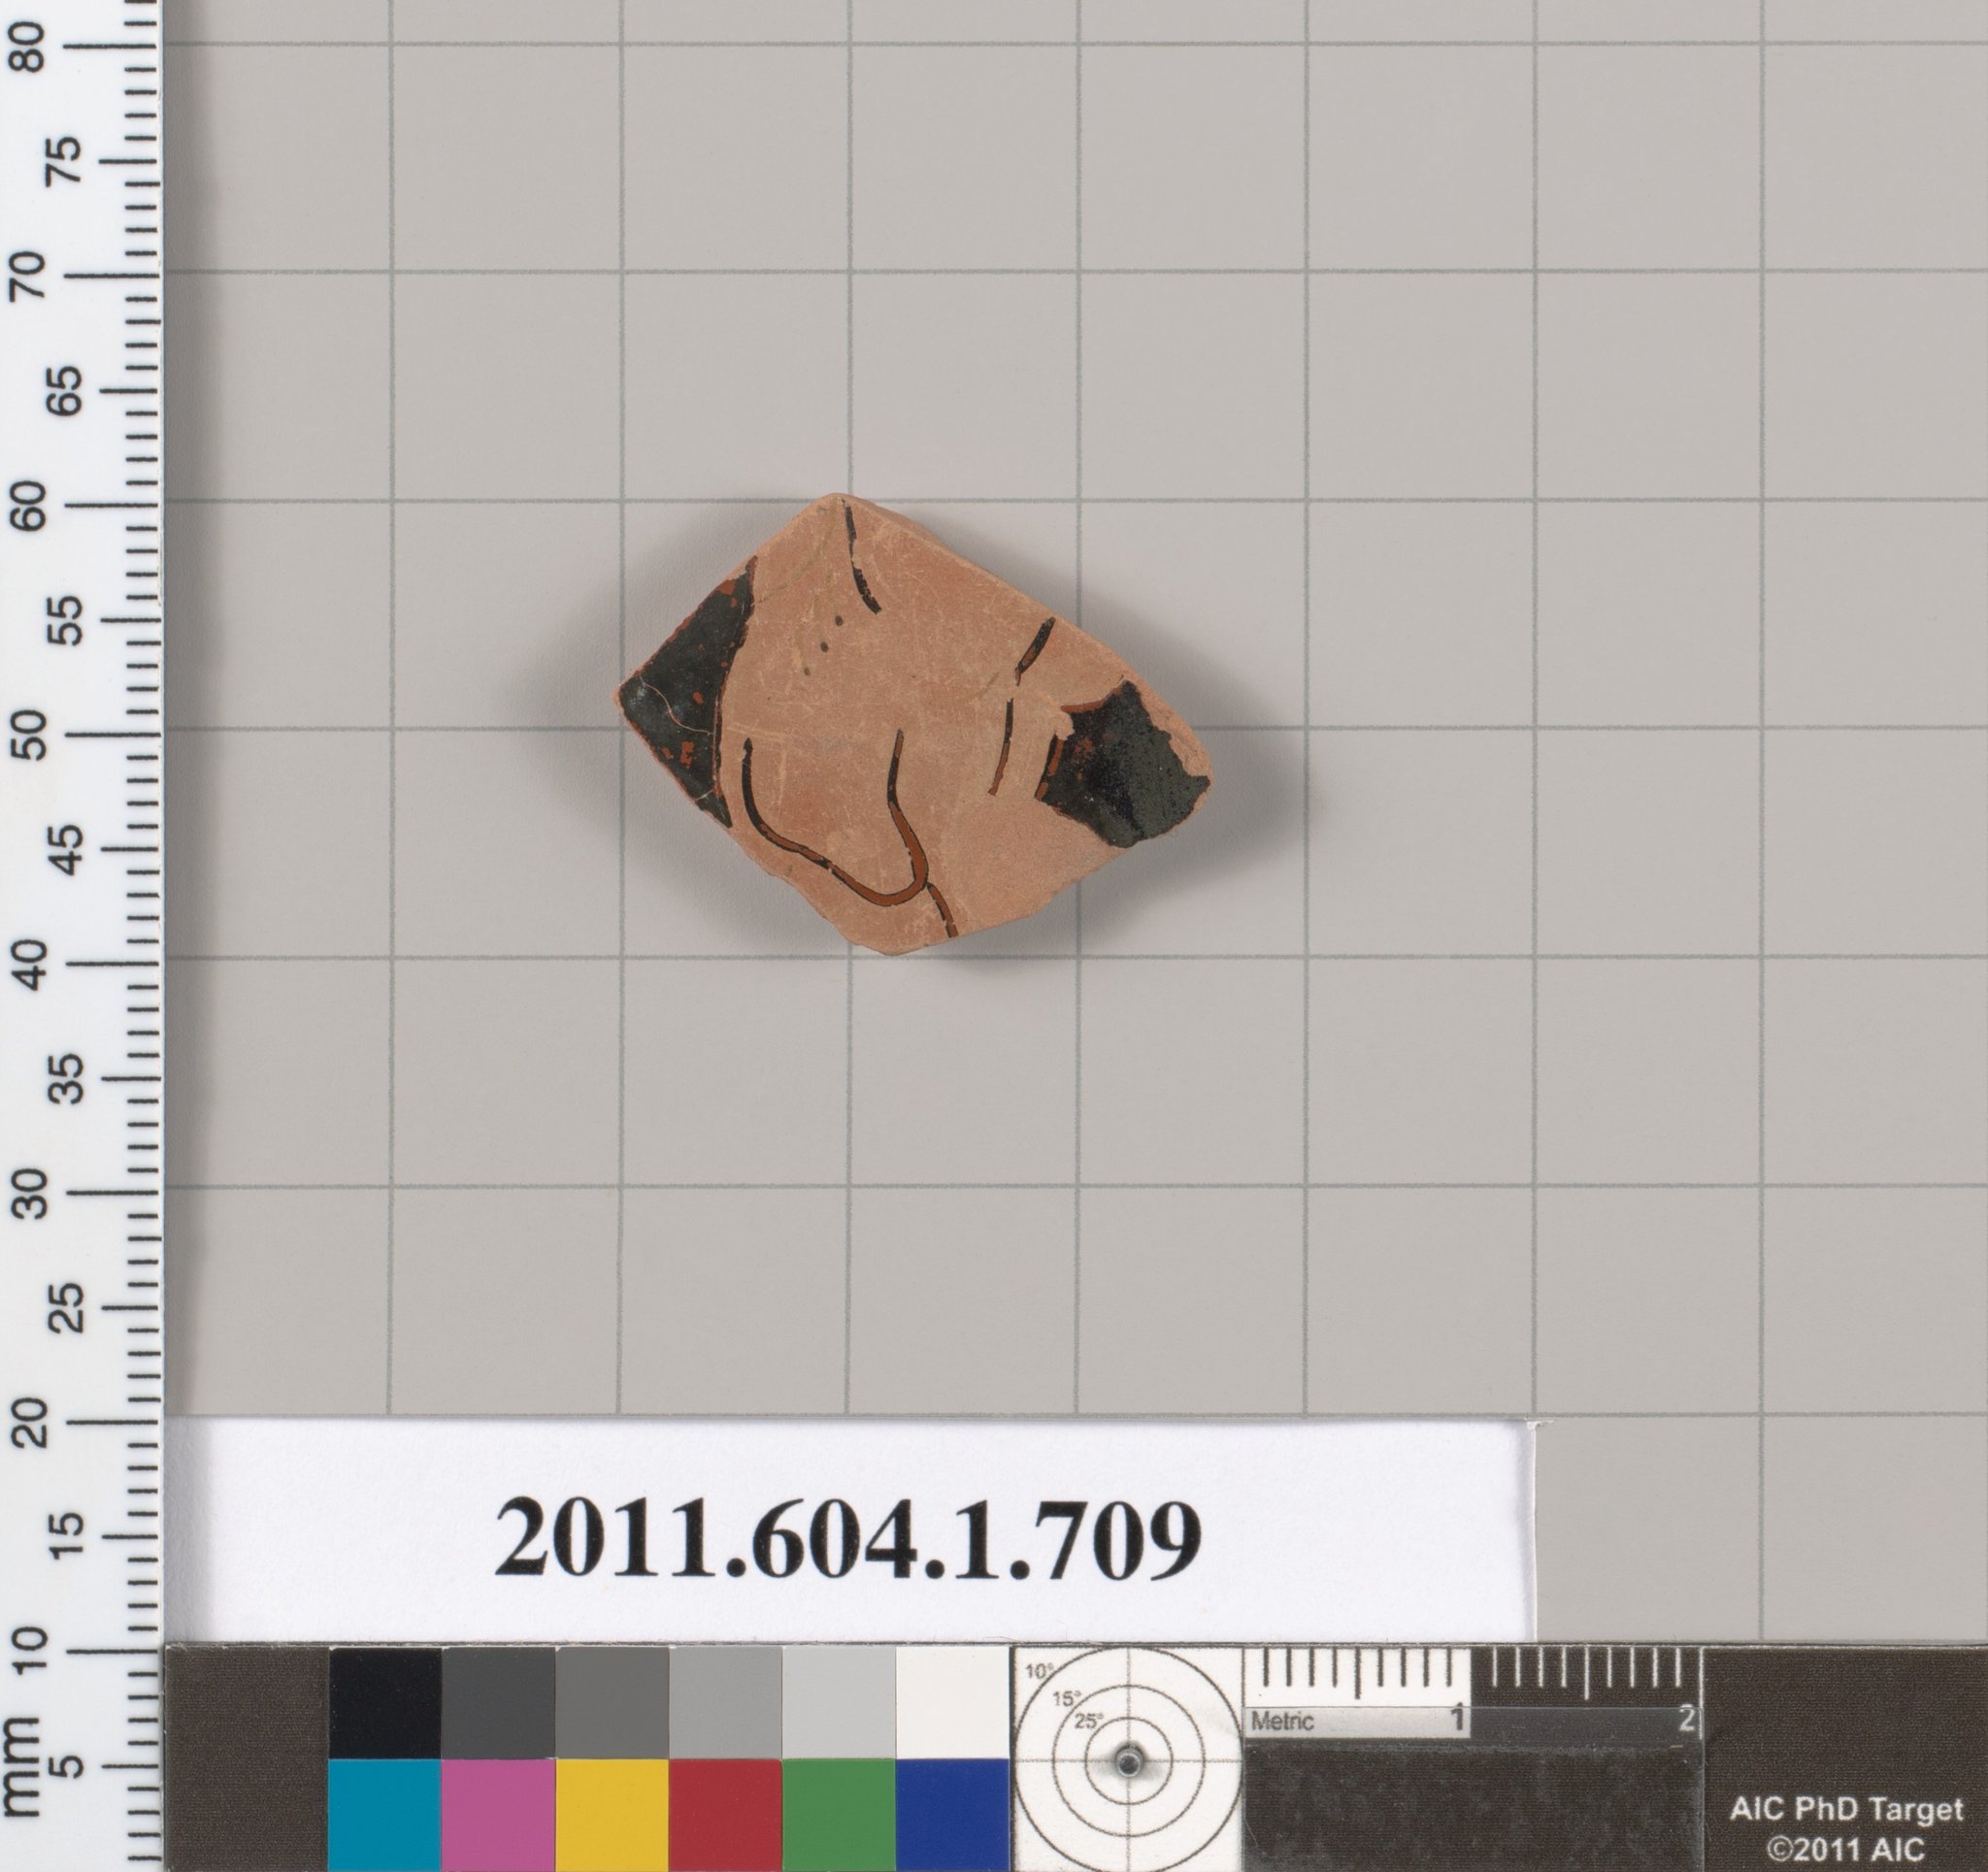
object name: kylix fragment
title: Terracotta fragment of a kylix (drinking cup)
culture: greek, attic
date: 500-451 BCE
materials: terracotta